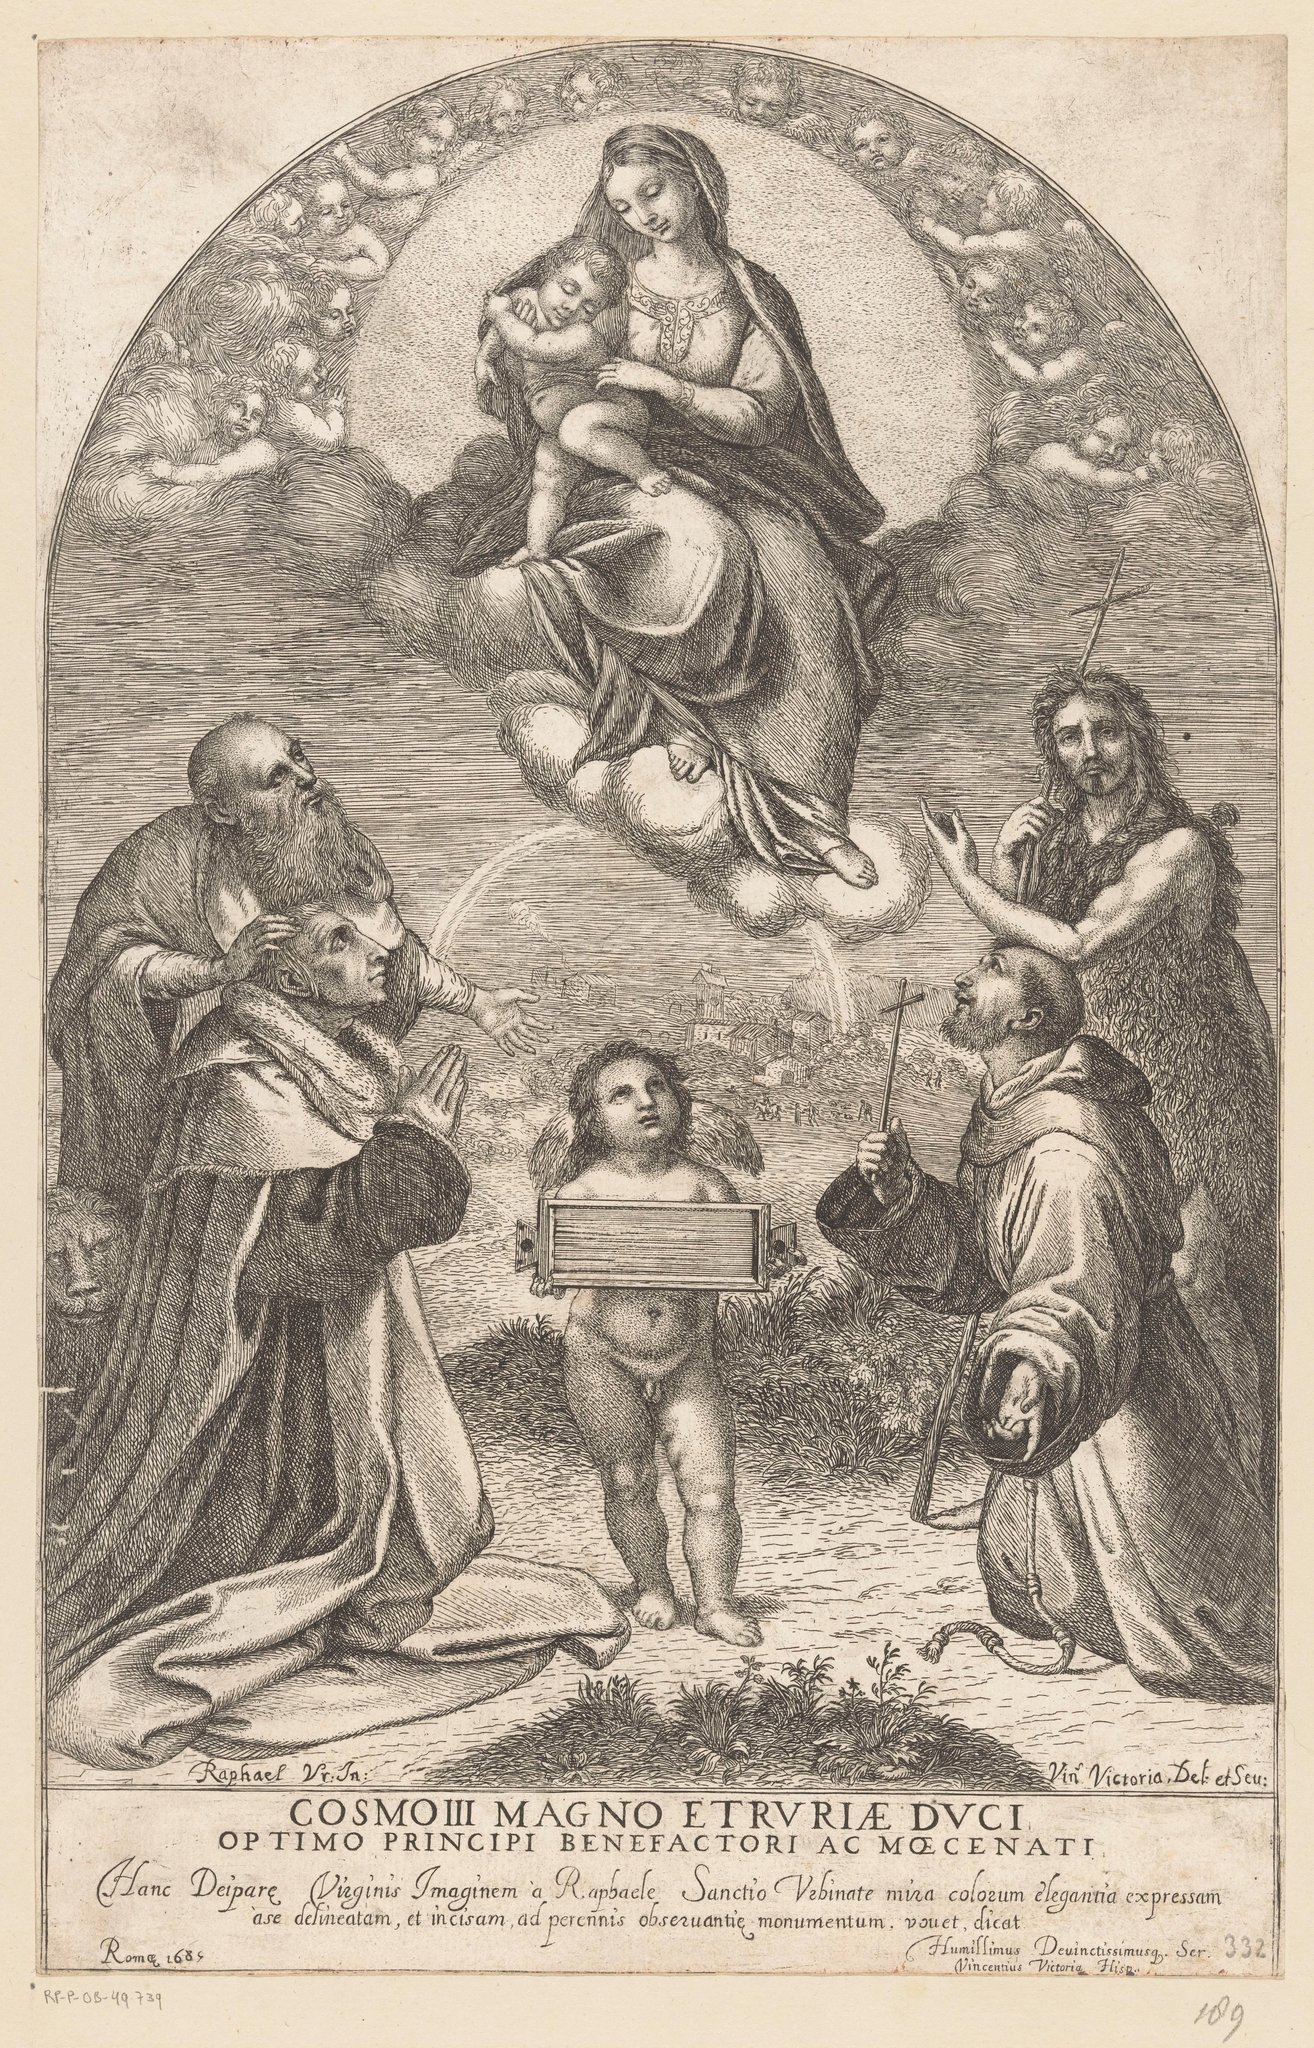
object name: print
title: Maria met Kind aanbeden door heiligen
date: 1684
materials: paper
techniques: etching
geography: italy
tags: rome, john the baptist; possible attributes: book, reed cross, baptismal cup, honeycomb, lamb, staff, madonna accompanied by saint(s), founder of the order of friars minor (franciscans), francis(cus) of assisi; possible attributes: book, crucifix, lily, skull, stigmata, the monk and hermit jerome (hieronymus); possible attributes: book, cardinal's hat, crucifix, hour-glass, lion, skull, stone, cupids: 'amores', 'amoretti', 'putti', angels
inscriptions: collector's mark: Lugt 240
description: Bovenaan Maria met het Christuskind in de wolken, omringd door putti. Op de grond staat een engel met een houten bord in de handen. Links de humanist Sigismonde de' Conti en de heilige Hieronymus. Rechts de heiligen Franciscus en Johannes de Doper. Opdracht in het Latijn in ondermarge.